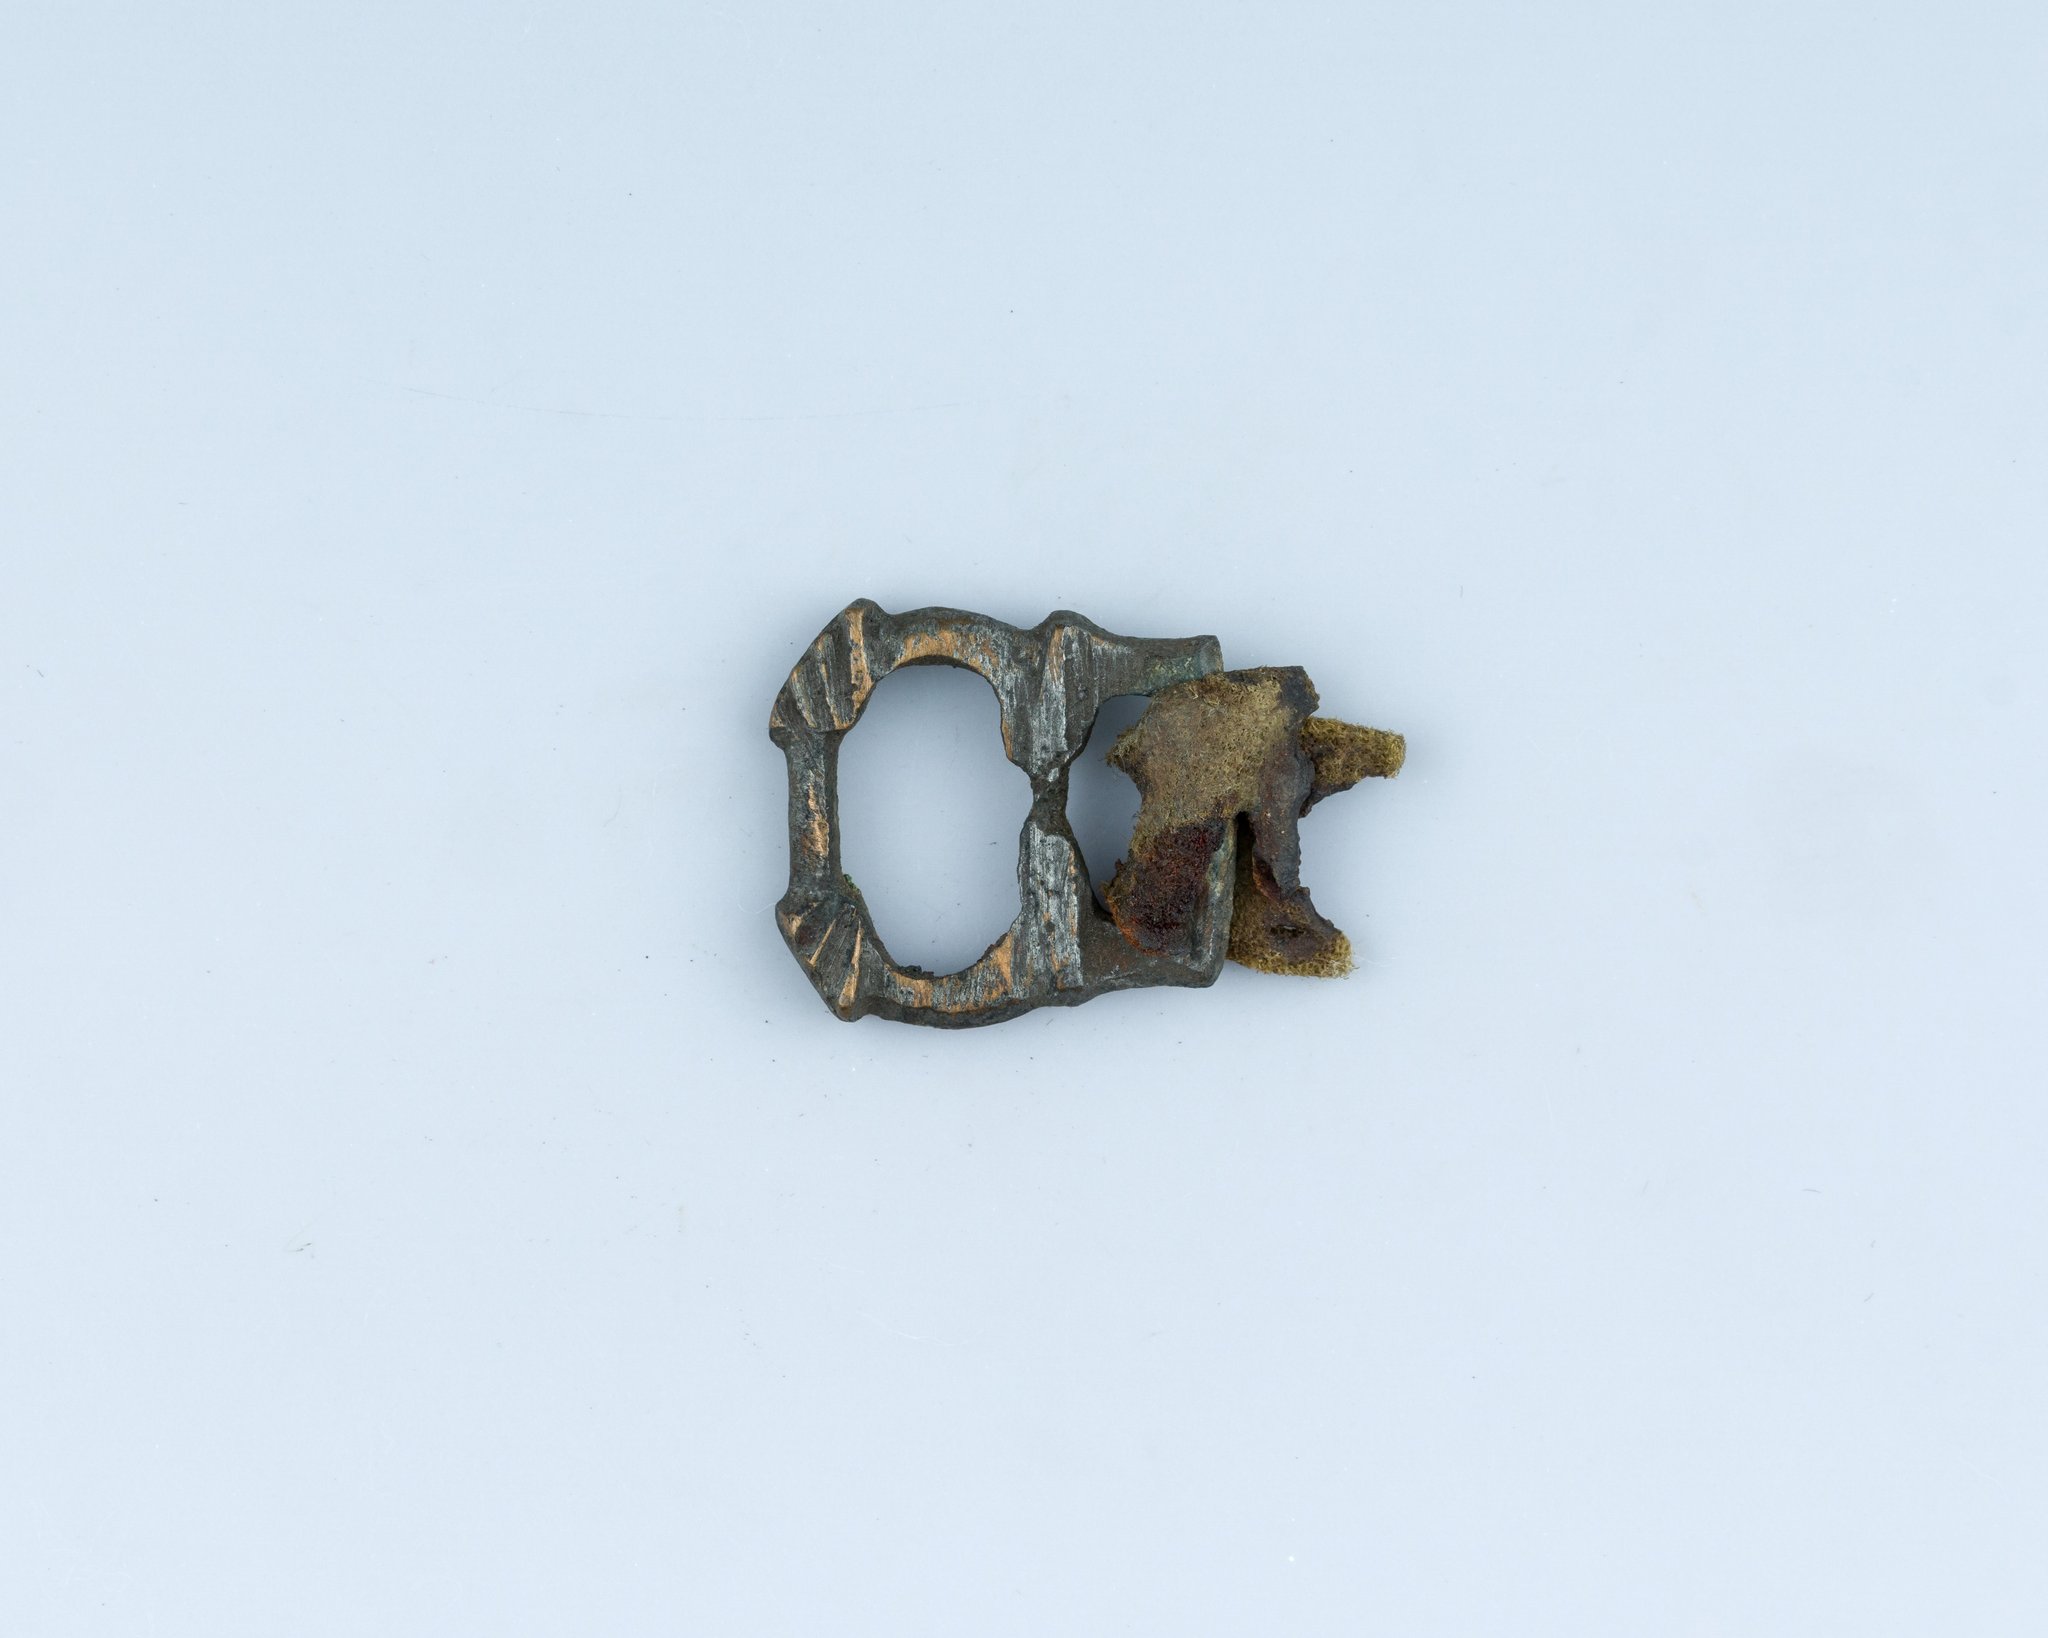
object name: buckle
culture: european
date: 1401-1700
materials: brass